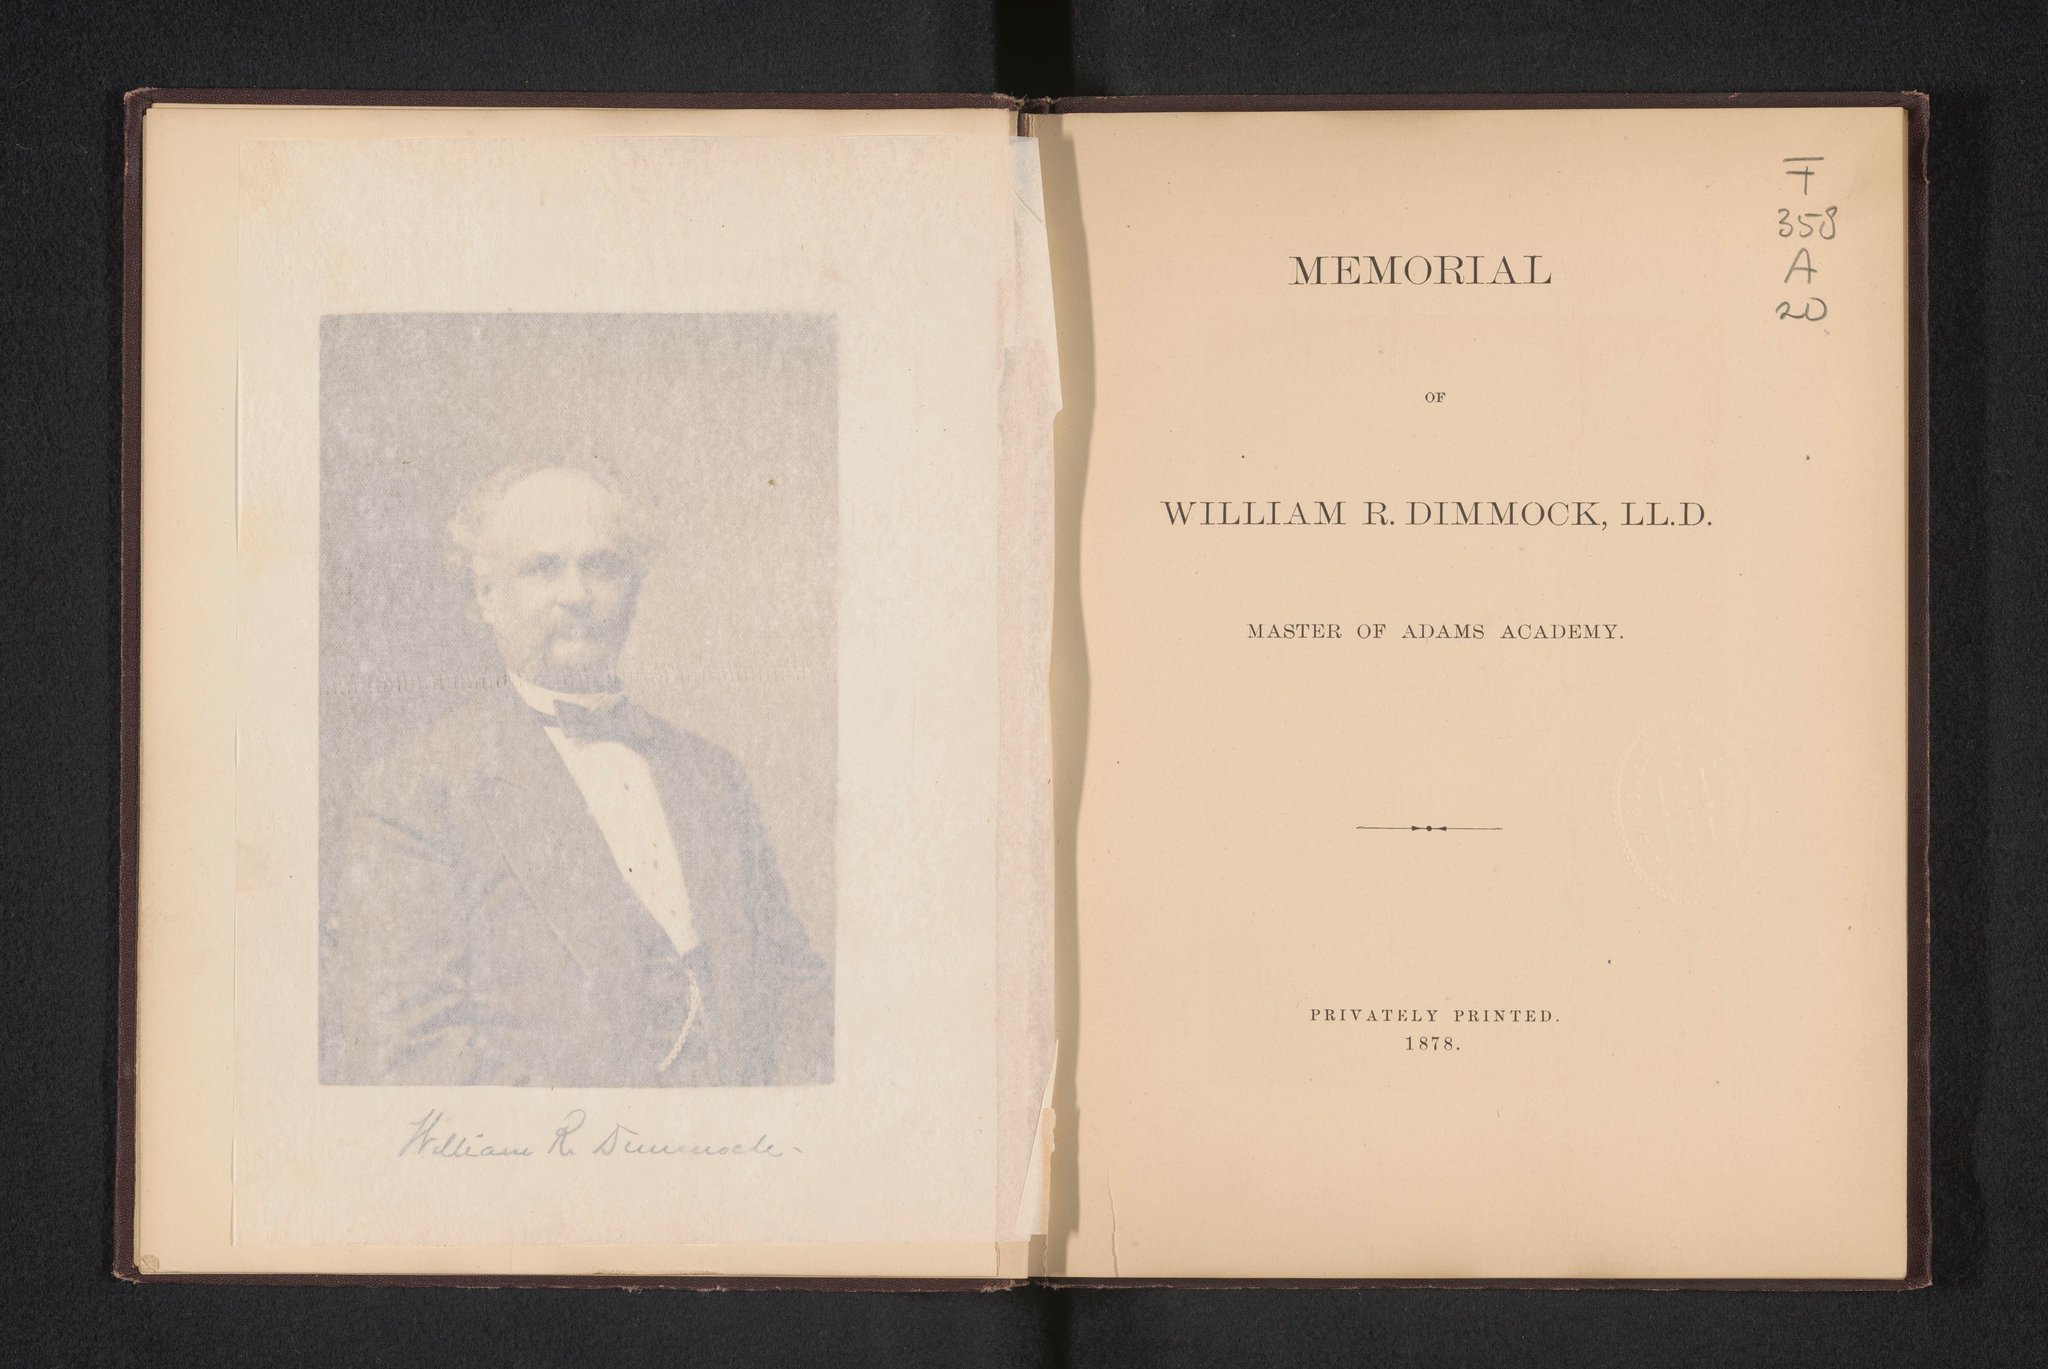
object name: book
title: Memorial of William R. Dimmock, master of Adam Academy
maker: t.r. marvin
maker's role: printer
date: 1878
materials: linen, paper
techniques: albumen print, printing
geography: boston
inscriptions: collector's mark: ‘New England Historic Genealogical Society/ Given by/ Madeline Reynolds [...]’, date: ‘May 20 1942’, collector's mark: ‘N.E. Historic Genealogical Society’, date: ‘May 1998’, date: ‘May 20 1942’, annotation: ‘48174/ 65-/ 3 orriginal photographic plates/ photography/ Adam's academy quincy Mass’